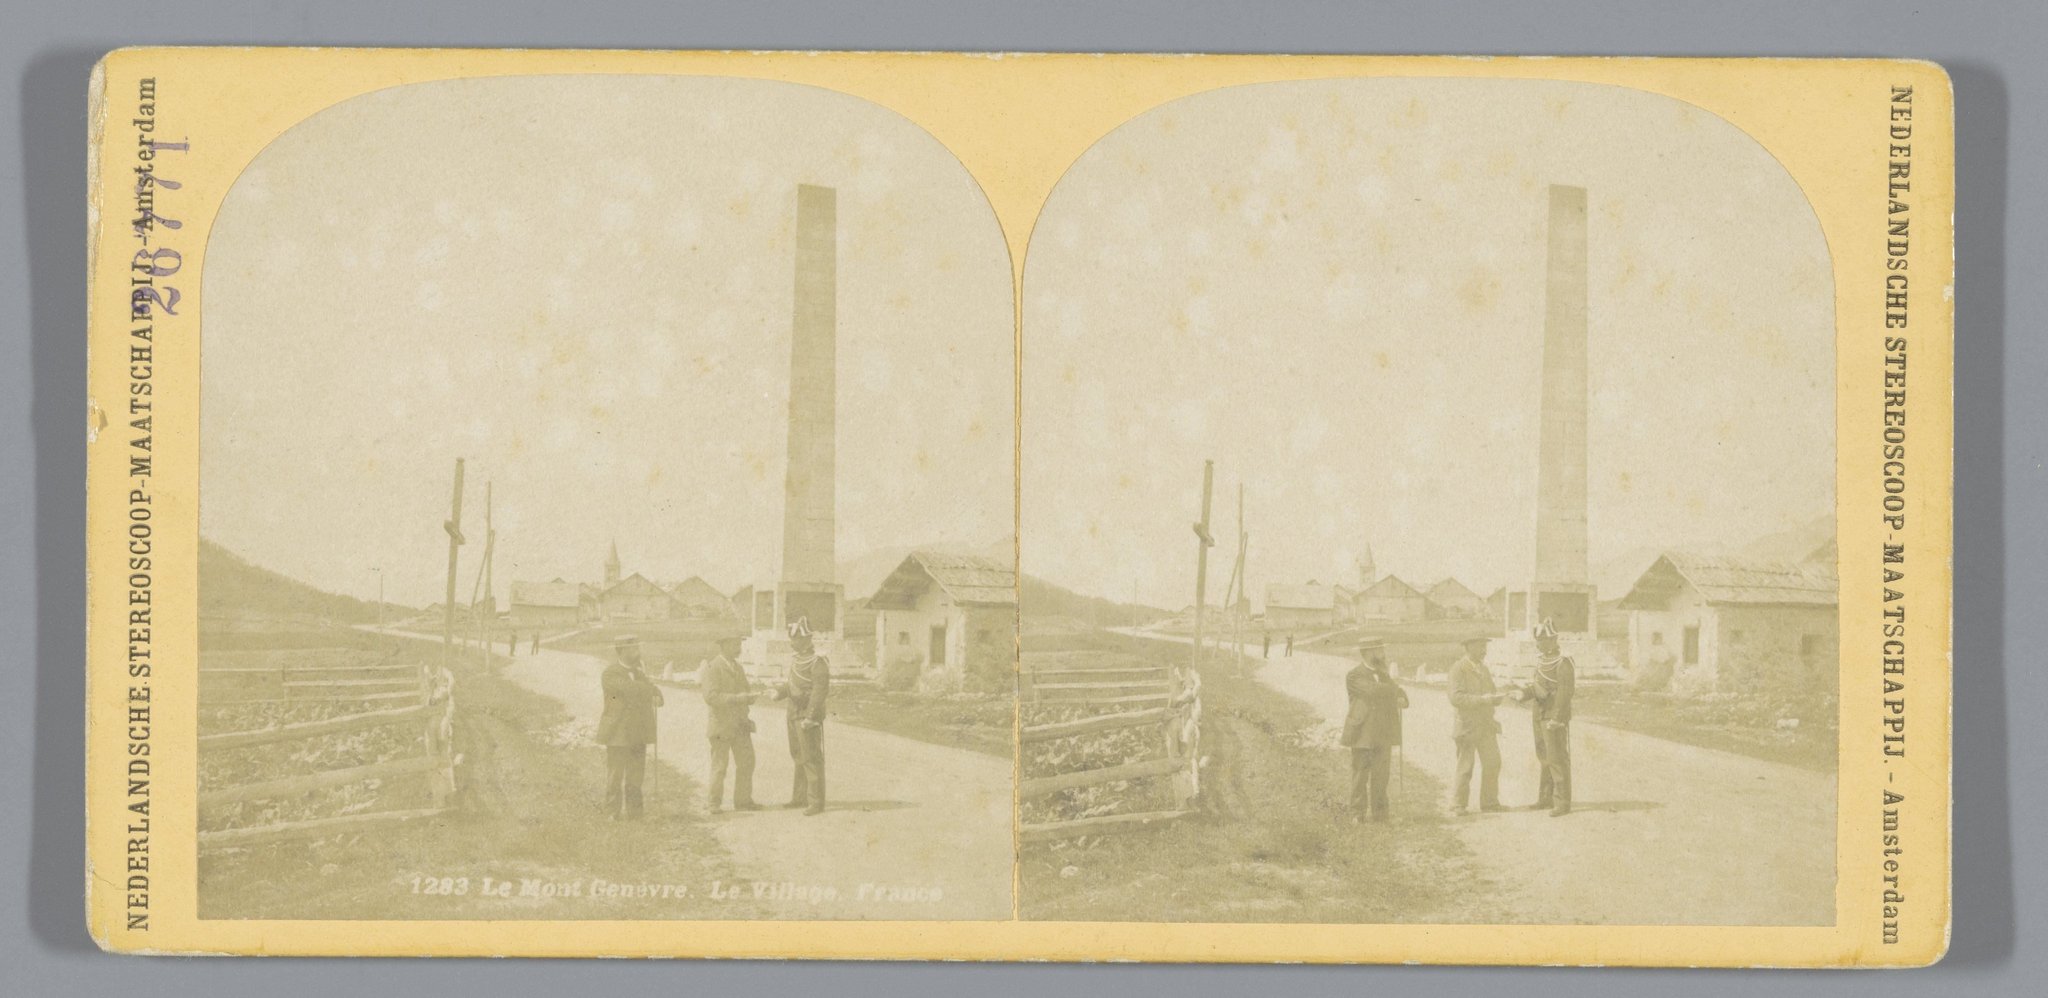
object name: stereograph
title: Gezicht op het monument voor de Montgenèvrepas bij Montgenèvre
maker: j.g. beers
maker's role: fotograaf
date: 1850-1880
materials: cardboard, photographic support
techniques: albumen print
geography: montgenèvre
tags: monument, statue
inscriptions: number: ‘26771’, number: ‘1283’